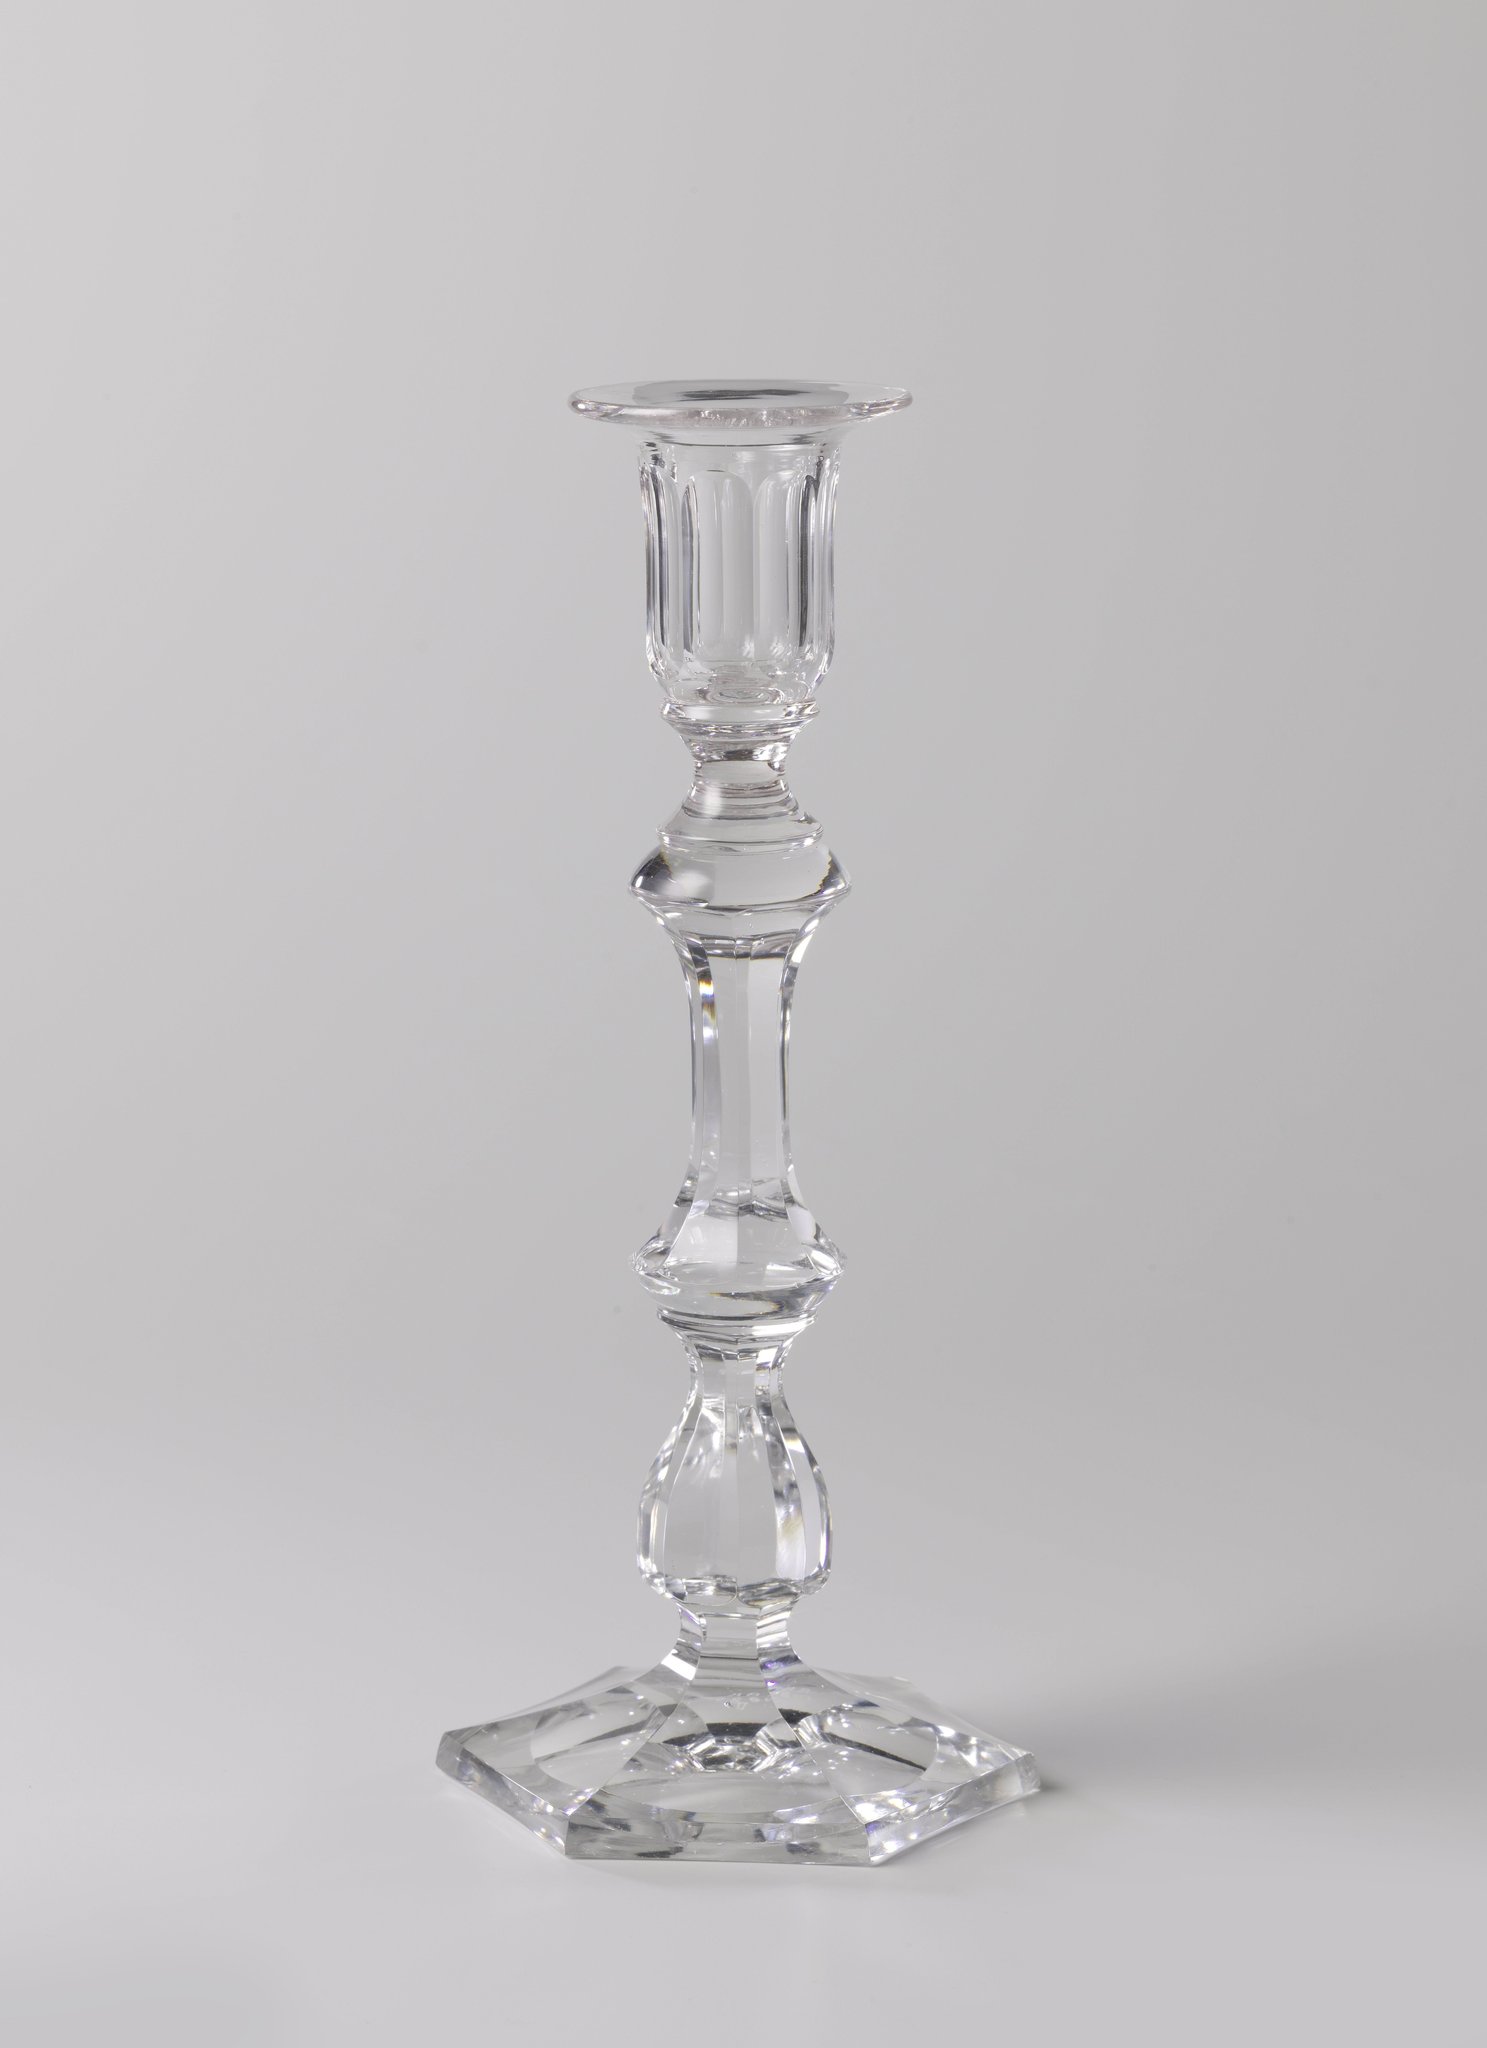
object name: candlestick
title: Kandelaar met geslepen facetten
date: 1850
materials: glass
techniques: glassblowing, grinding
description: Zeskantige, conische voet, balustervormige stam, cylindervormige houder met uitgebogen rand. Facetgelepen voet, stam en houder.